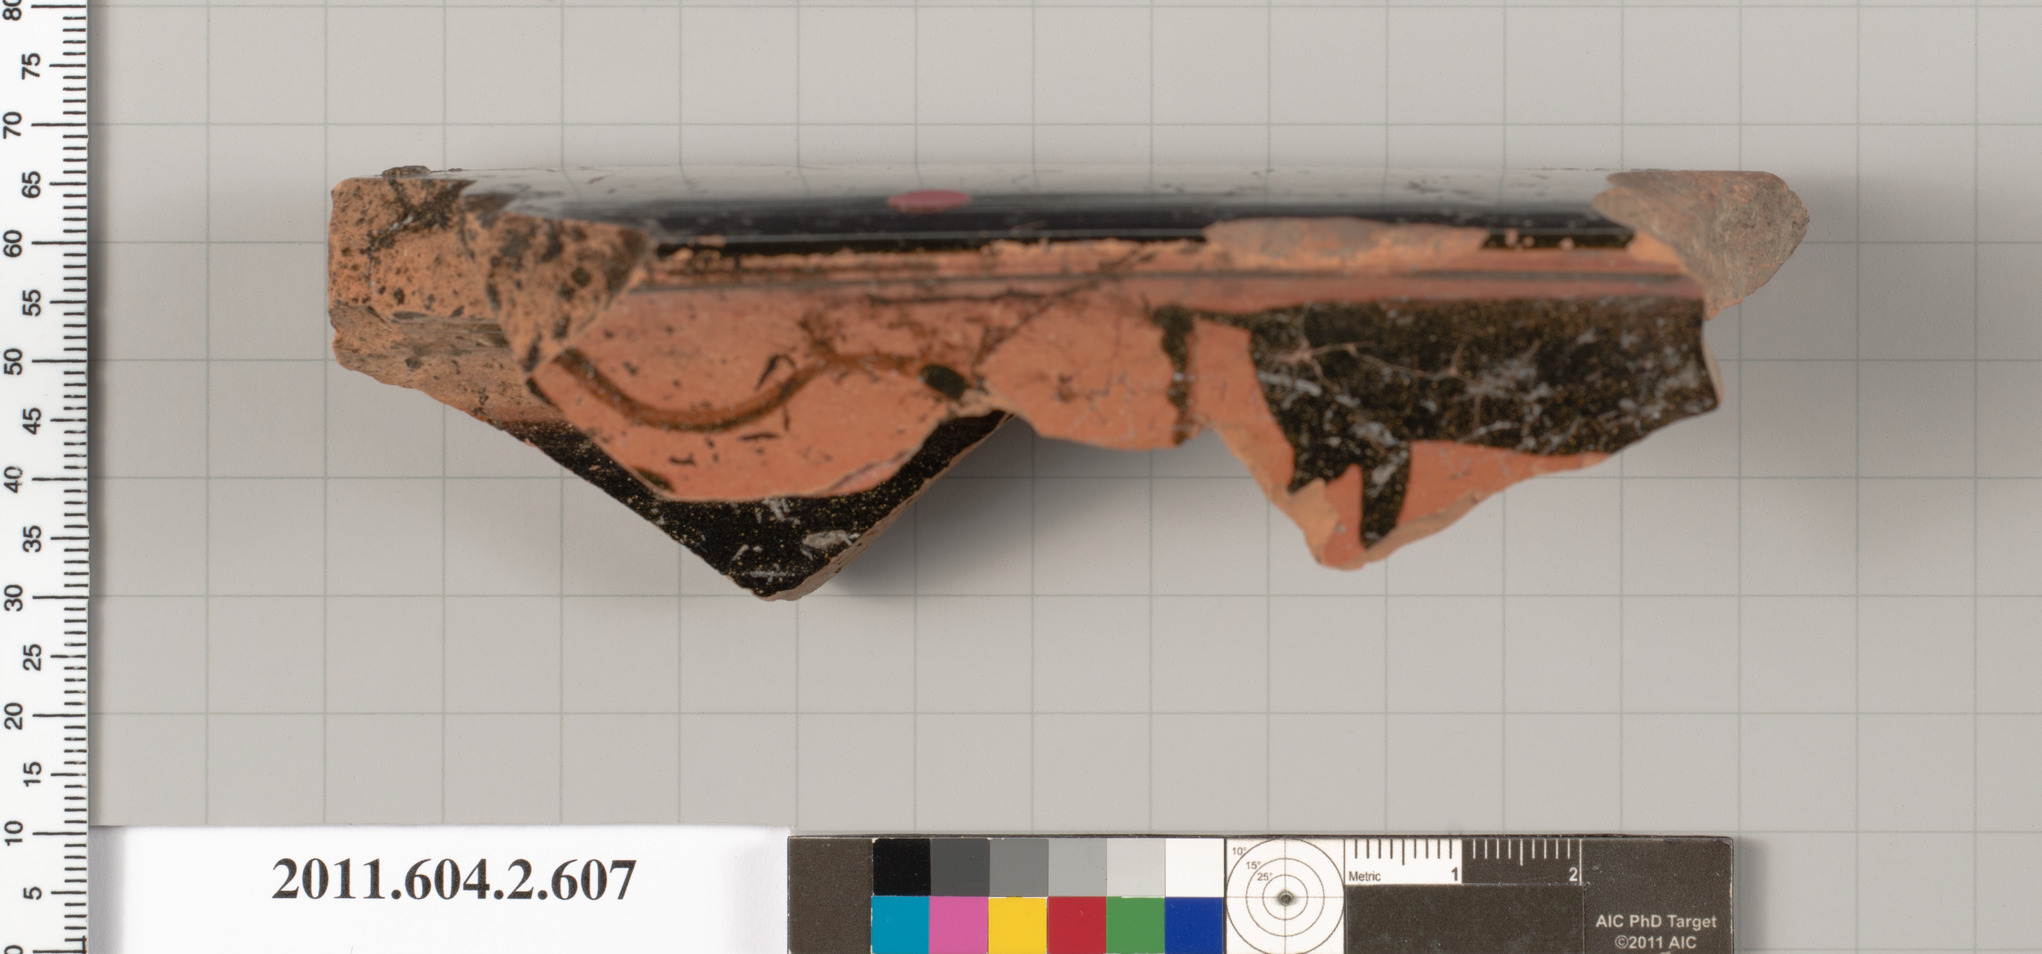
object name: column krater fragment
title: Terracotta fragment of a column-krater (bowl for mixing wine and water)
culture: greek, attic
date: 475-451 BCE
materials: terracotta